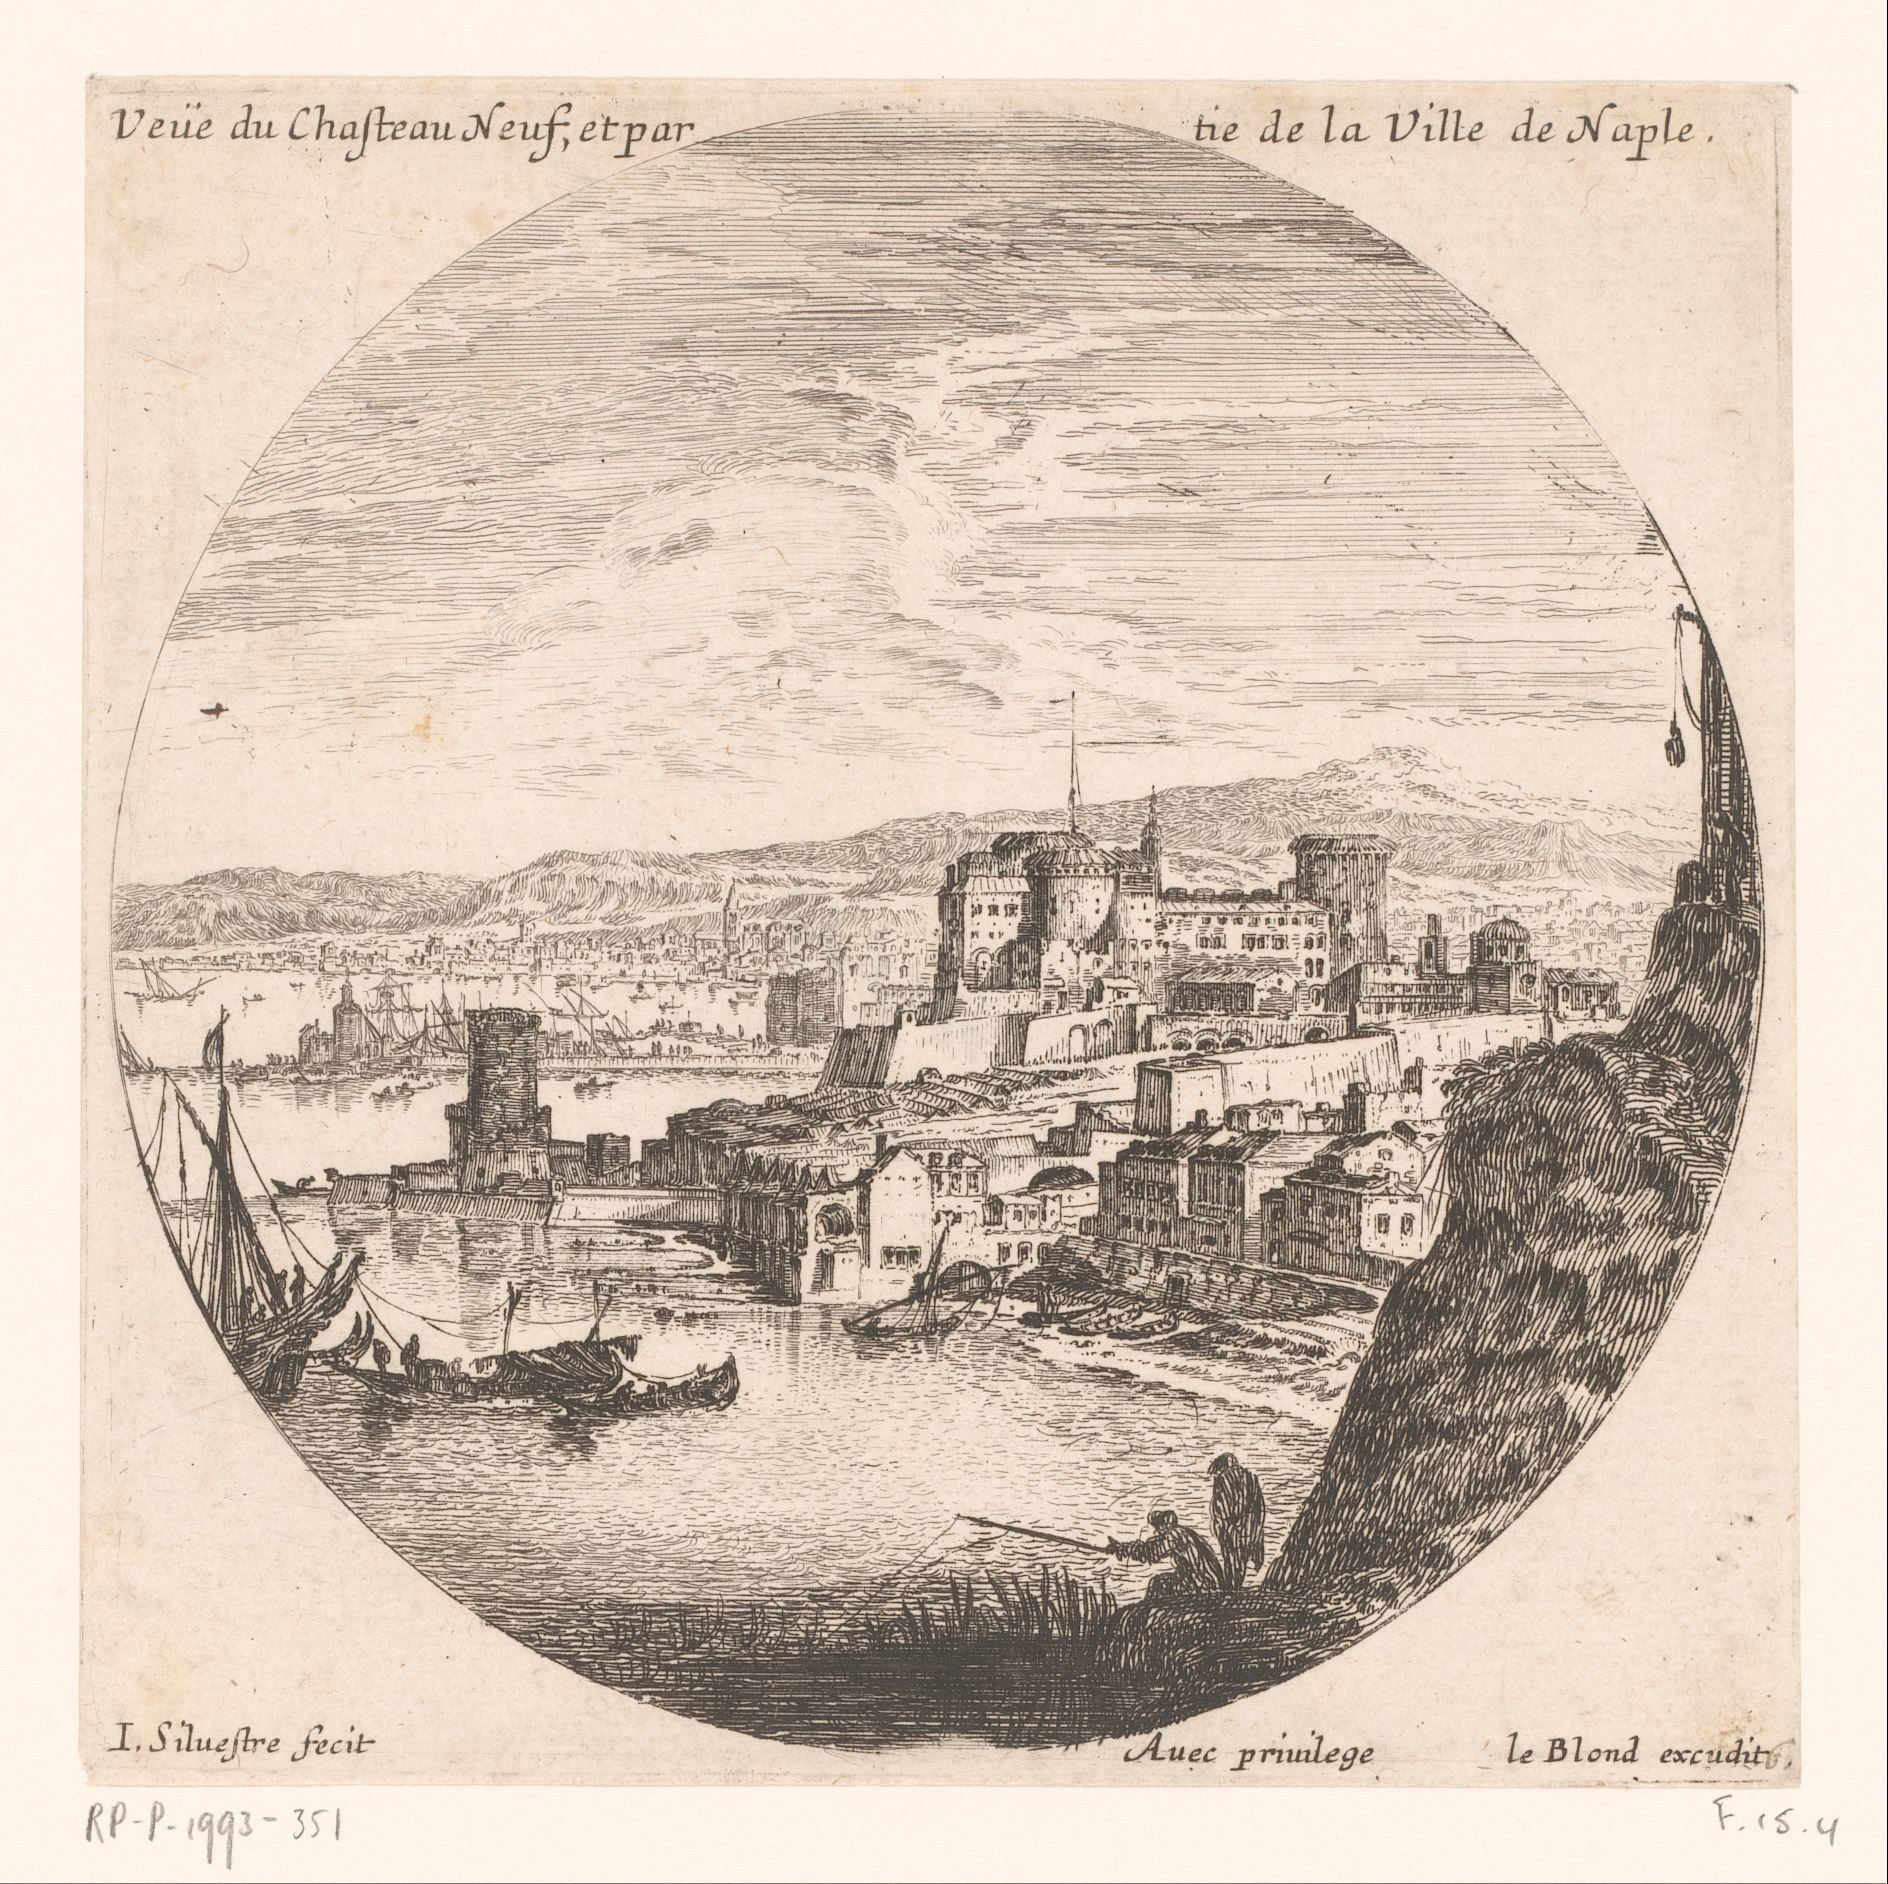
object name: print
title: Gezicht op Castel Nuovo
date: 1648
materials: paper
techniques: etching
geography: france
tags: harbour, city-view in general; 'veduta'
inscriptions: collector's mark: Lugt 2228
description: Prent maakt deel uit van een ongenummerde serie van zes prenten.